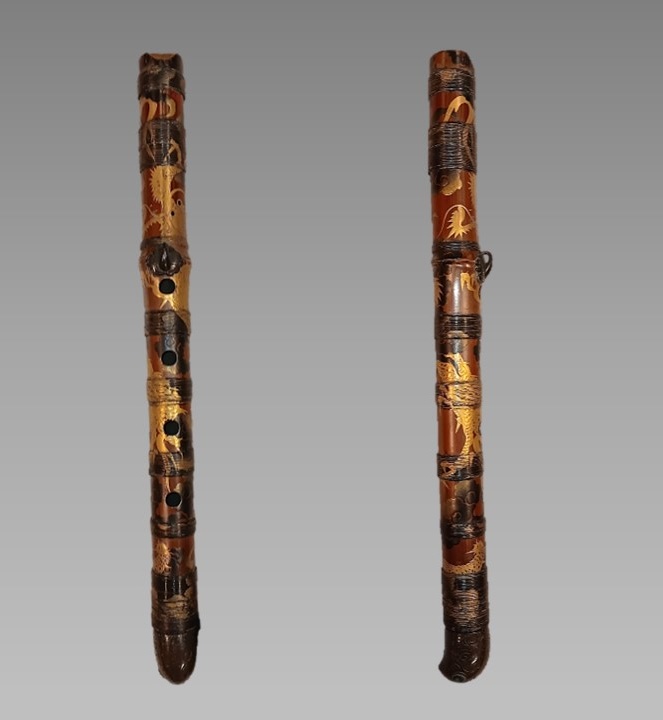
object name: hitoyogiri 一節切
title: Hitoyogiri (一節切)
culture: japanese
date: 1601-1633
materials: gilt, lacquer, wood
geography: japan